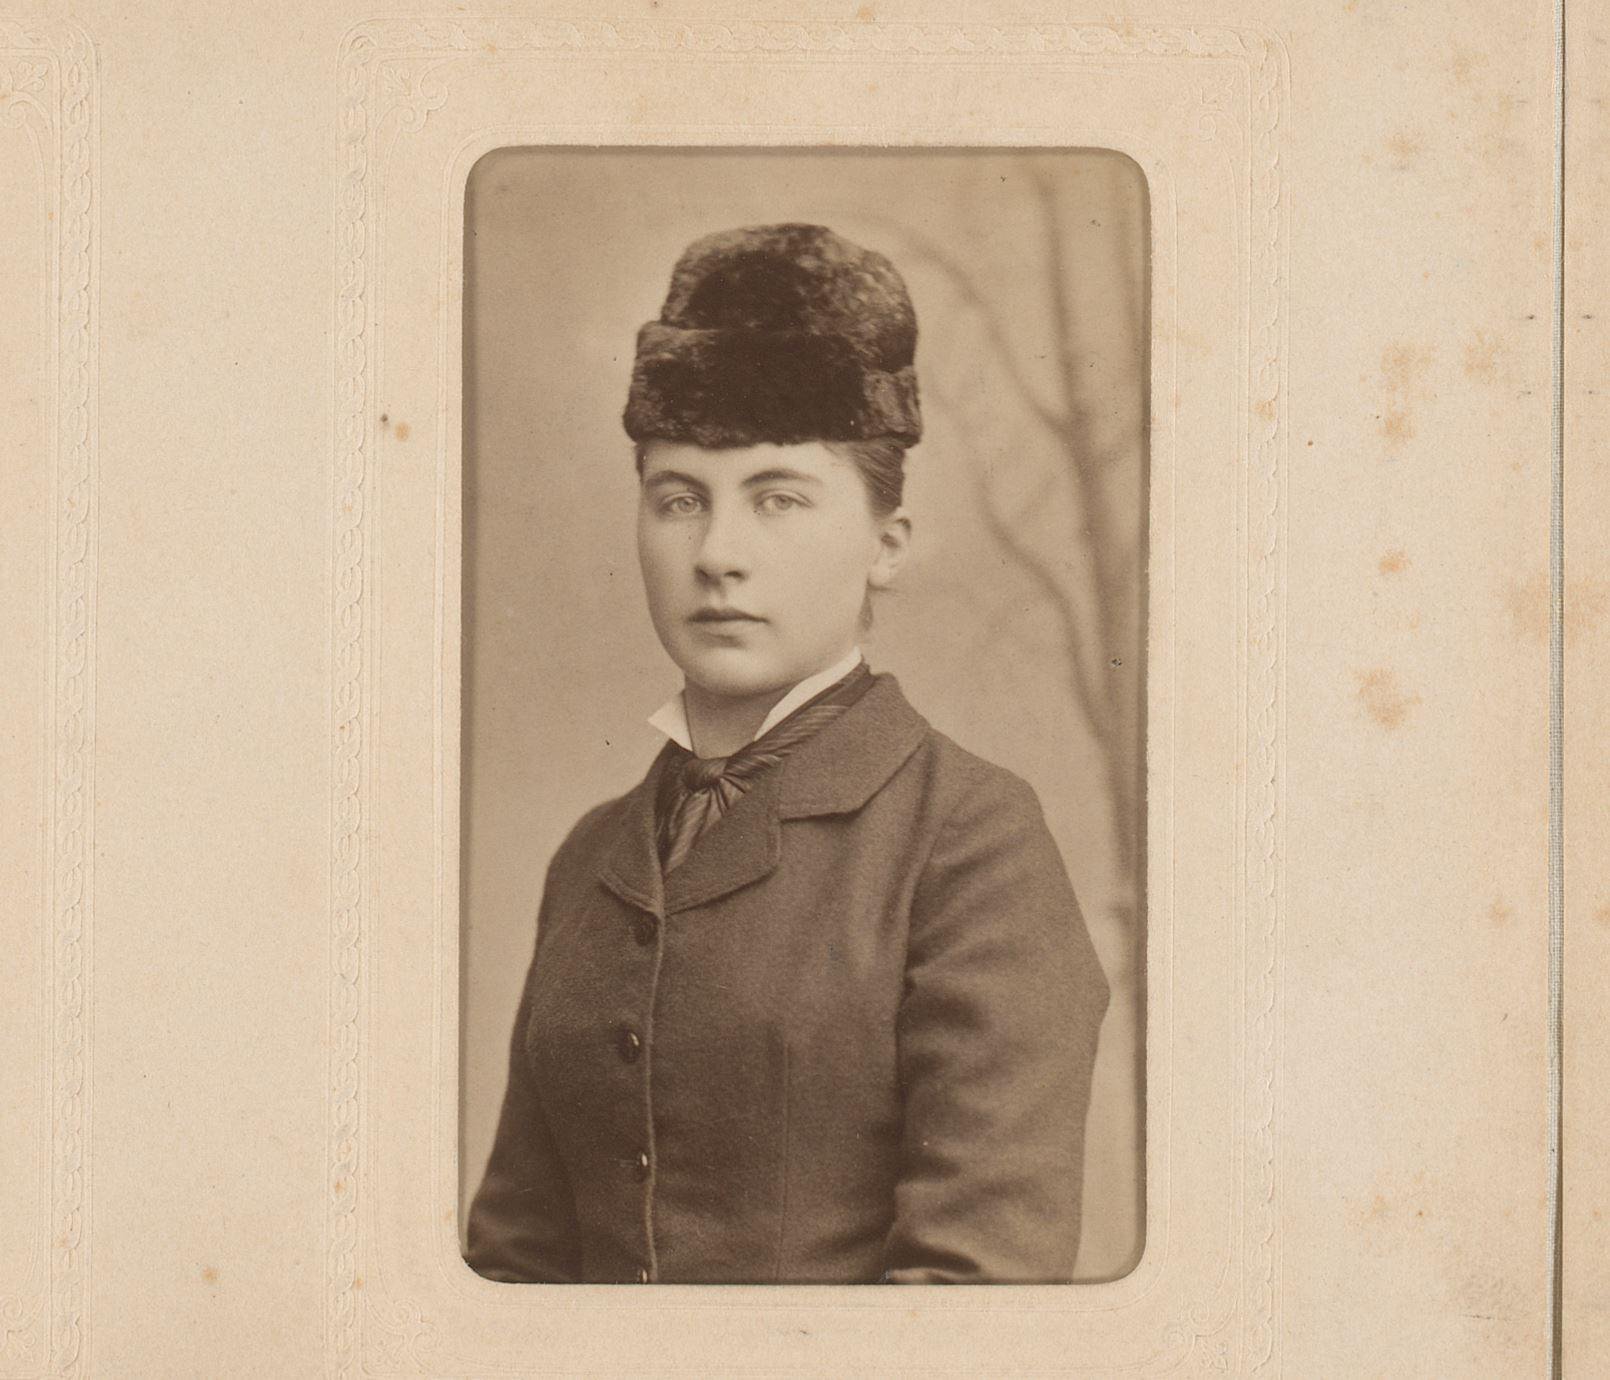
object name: carte de visite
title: Portret van een jonge vrouw met bontmuts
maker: leopold bude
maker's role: fotograaf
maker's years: 1840-1907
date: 1880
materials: cardboard, photographic support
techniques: albumen print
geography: graz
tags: adolescent, young woman, maiden, historical persons - bb - woman, head-gear: cap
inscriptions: inscription: ‘Leopold Bude GRAZ.’, date: ‘M[...] 1880’